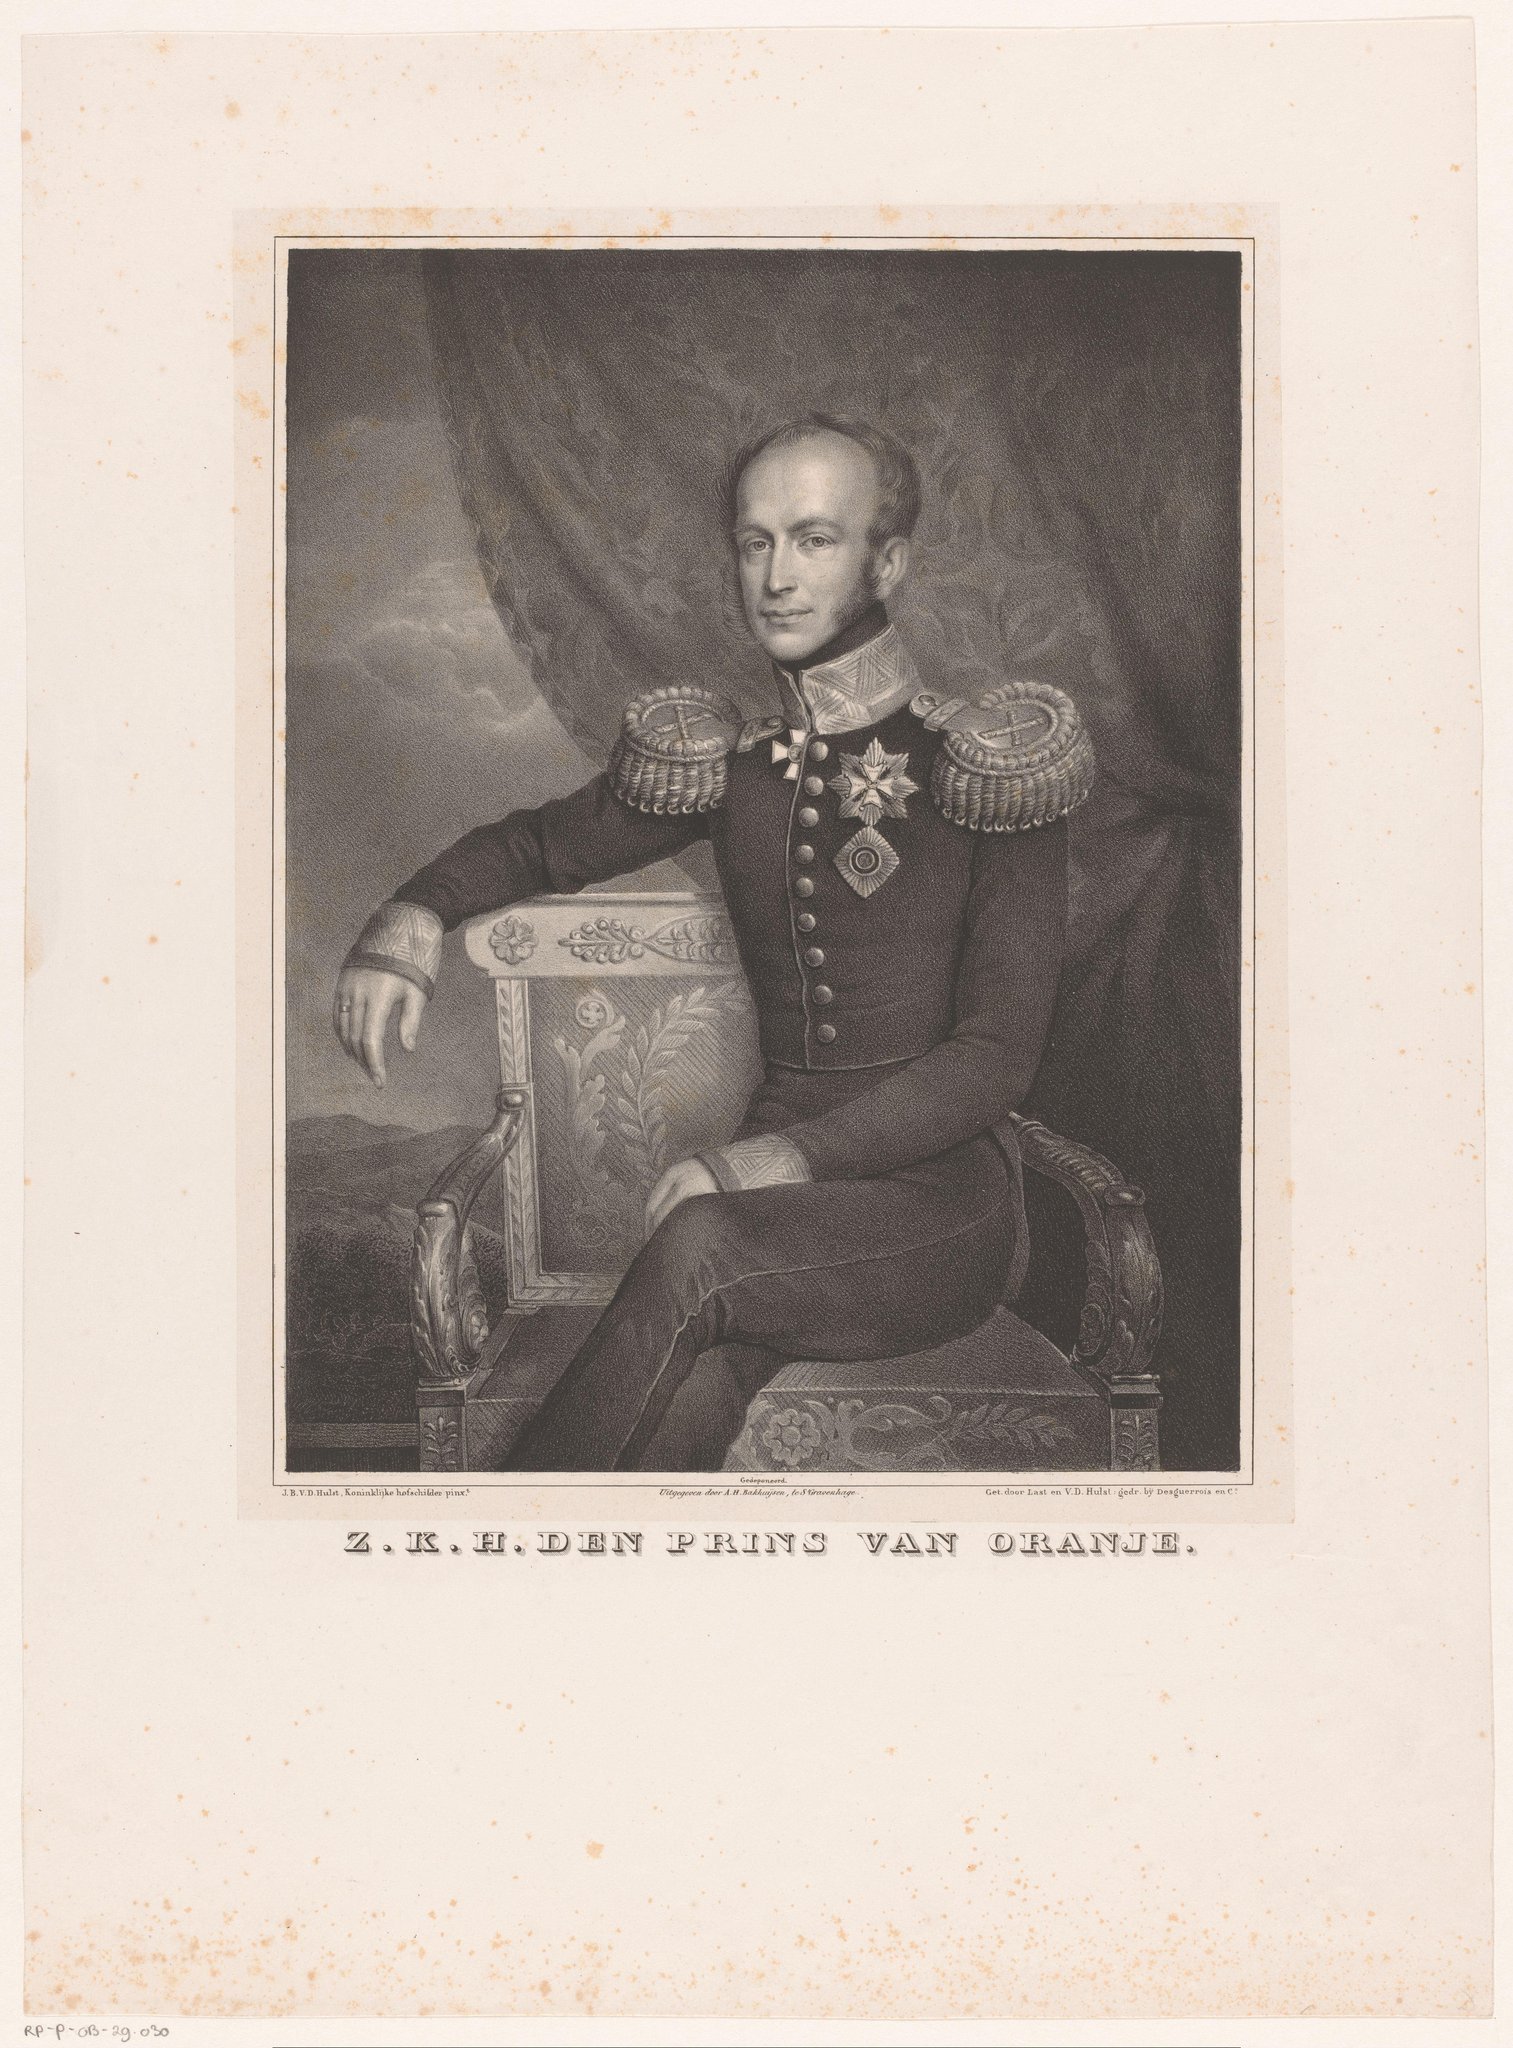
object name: print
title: Portret van Willem II, koning der Nederlanden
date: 1831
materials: paper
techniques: lithograph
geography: the hague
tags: knighthood order, hangings and drapery, historical persons (+ three-quarter length portrait)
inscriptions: collector's mark: Lugt 2228, : ‘Gedeponeerd.’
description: De geportretteerde draagt een militair uniform met ridderorden en epauletten (veldmaarschalk). Hij zit op een stoel met zijn rechterarm over de leuning. Achter hem een draperie en een landschap.